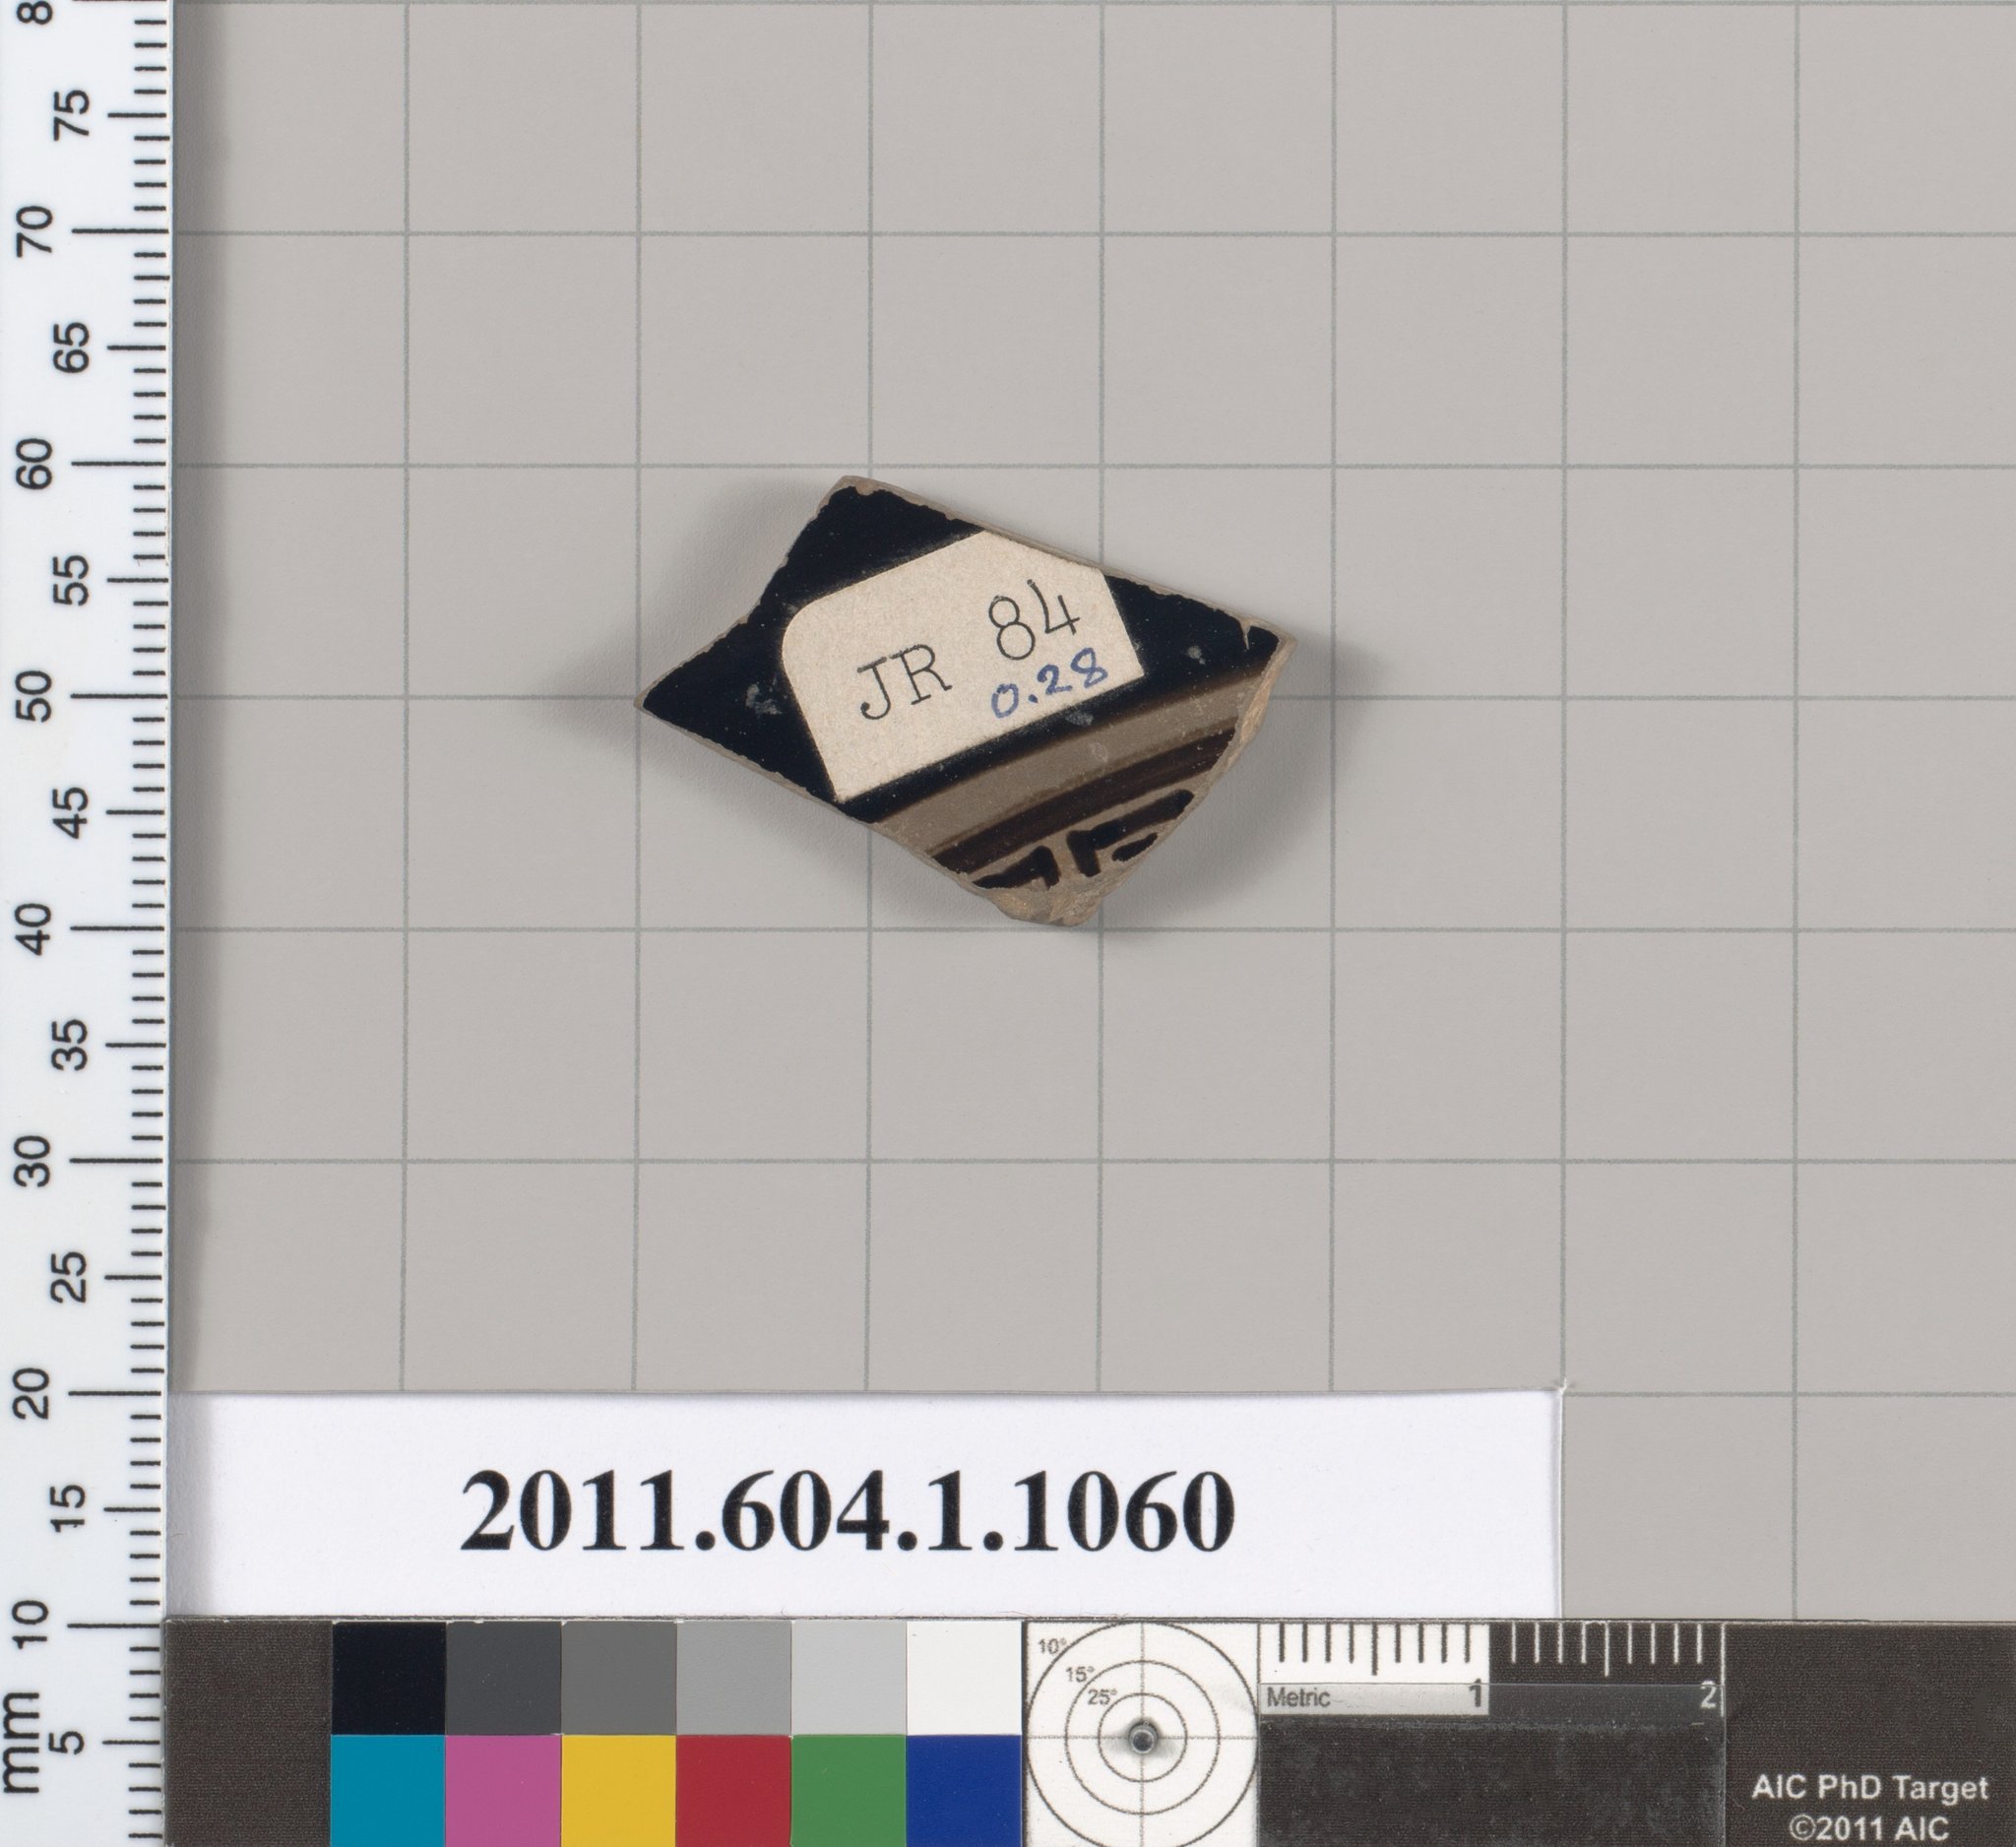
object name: kylix fragment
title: Terracotta fragment of a kylix (drinking cup)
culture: greek, attic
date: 490-480 BCE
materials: terracotta